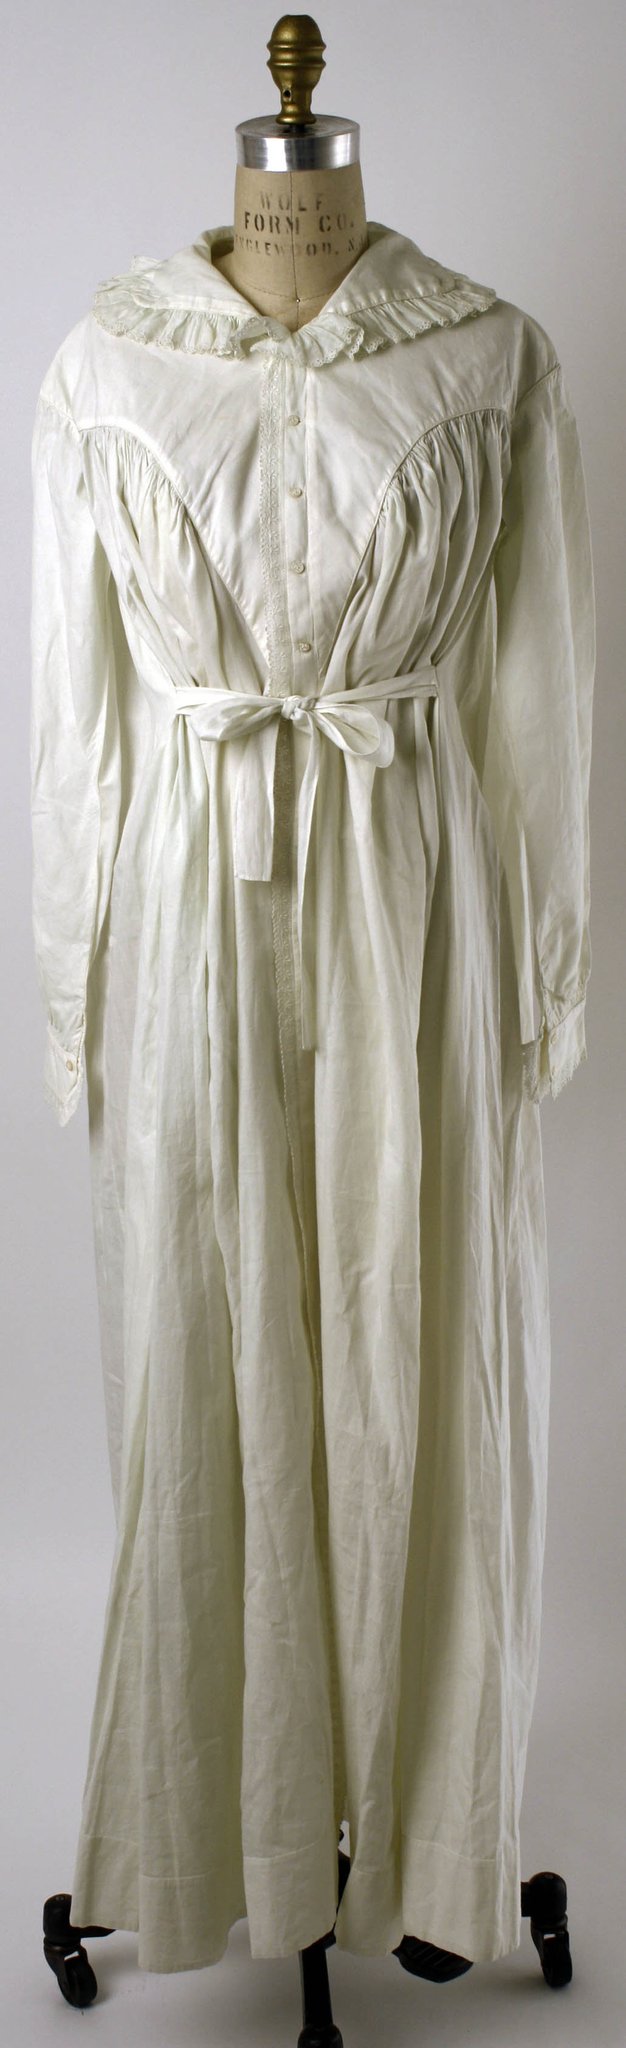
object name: nightgown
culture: american or european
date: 1821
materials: linen